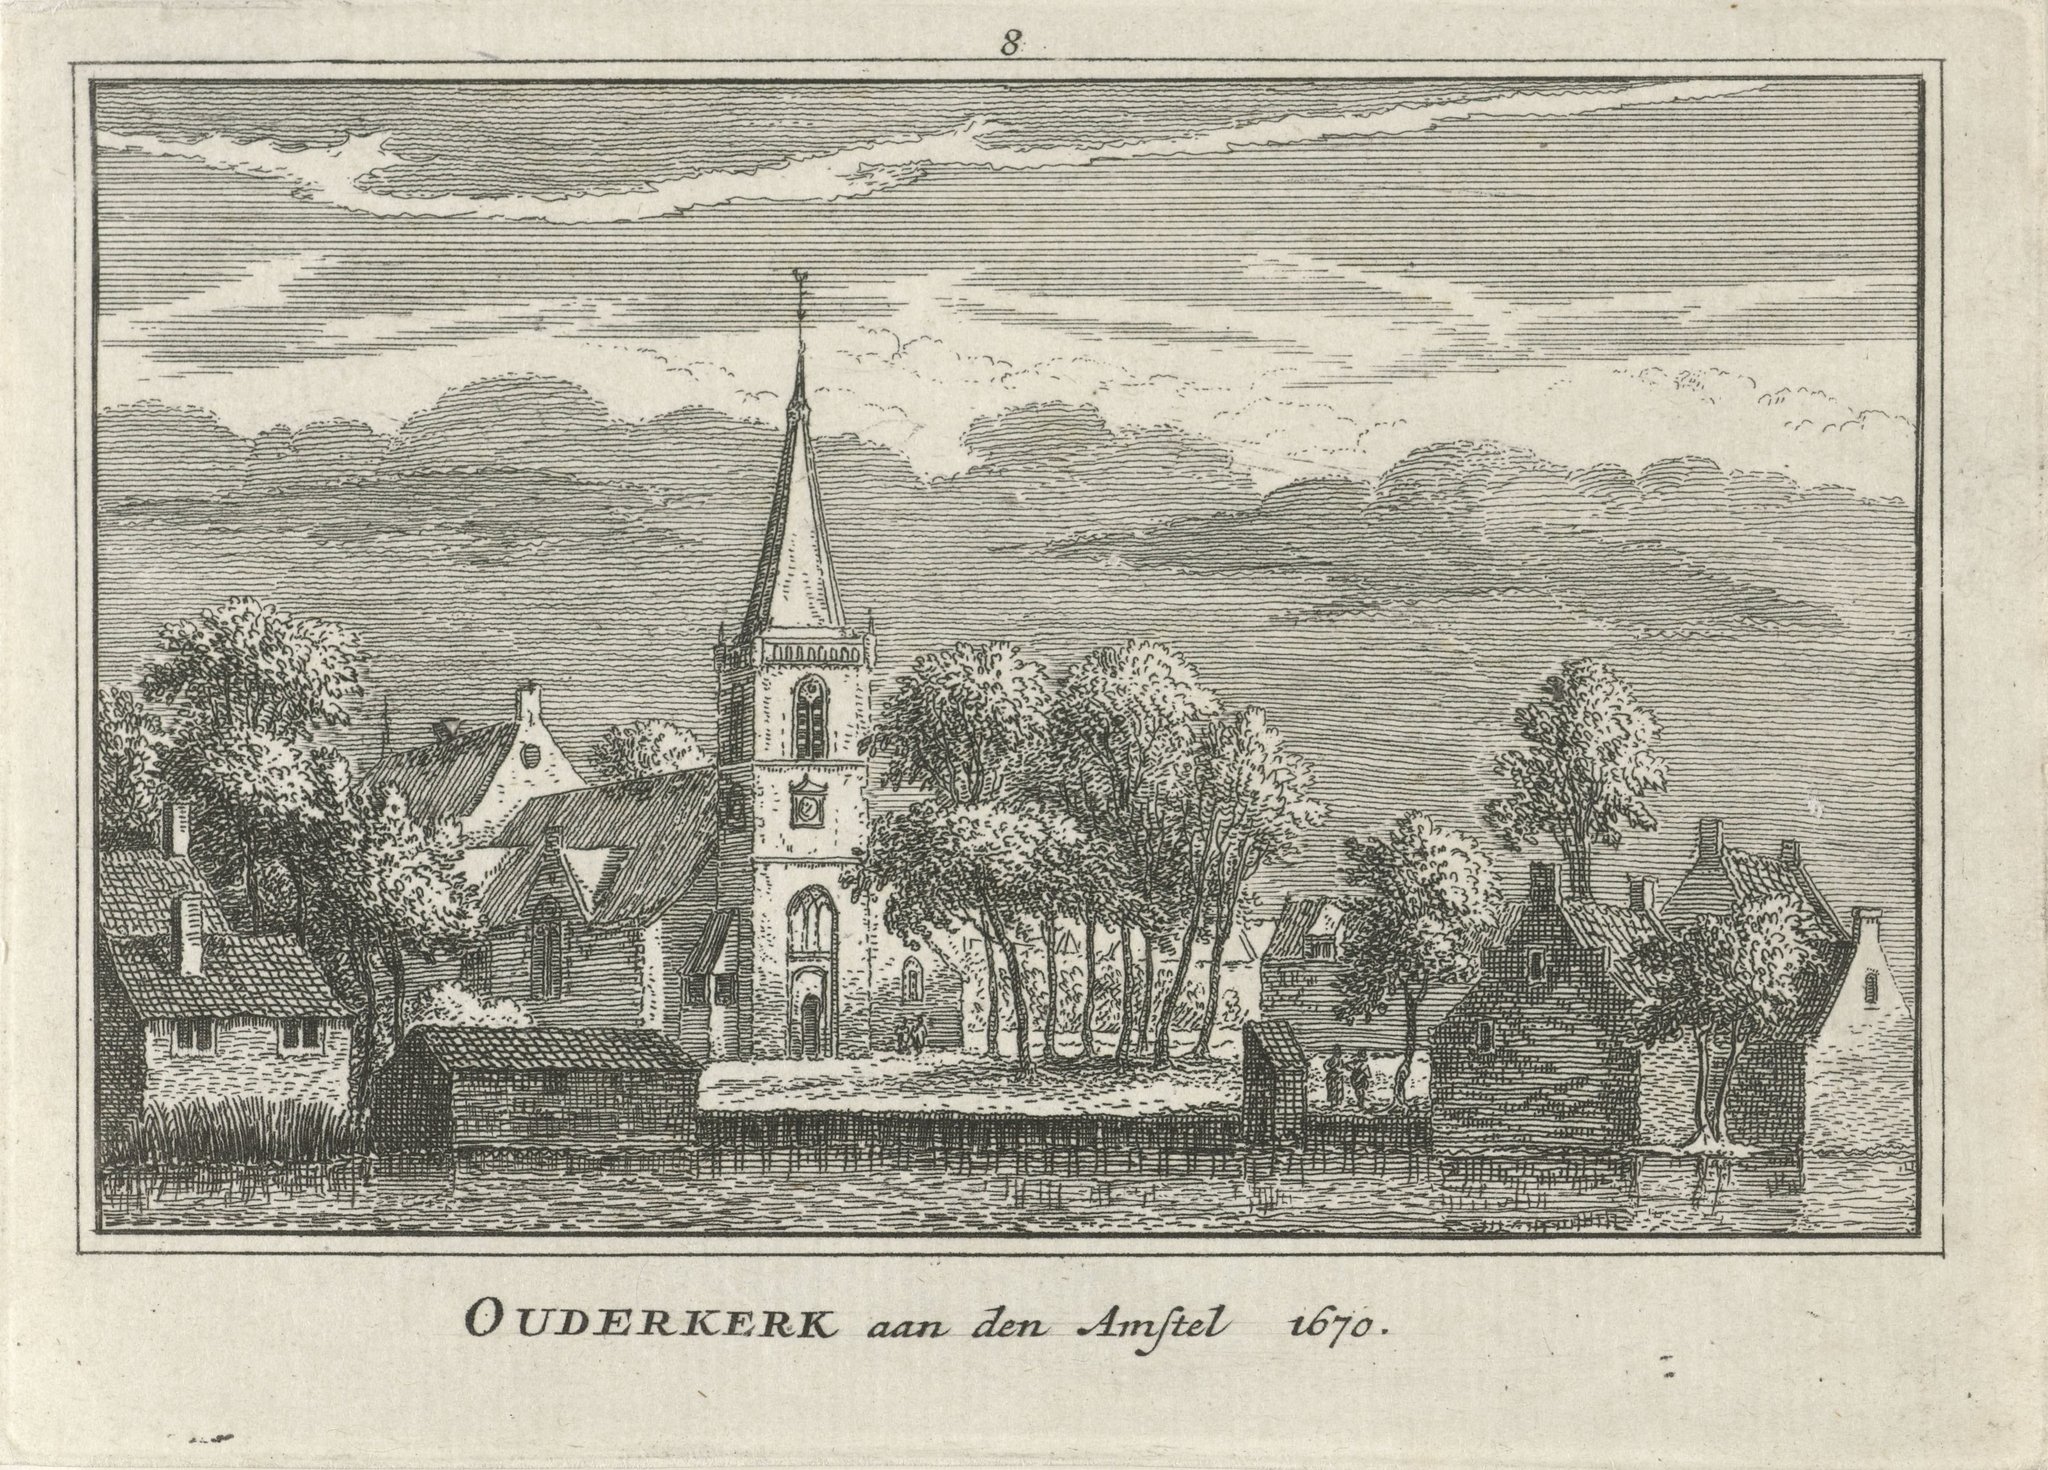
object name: book illustration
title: Ouderkerk aan den Amstel 1670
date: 1727-1733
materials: paper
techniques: etching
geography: amsterdam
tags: church (exterior)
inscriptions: collector's mark: Lugt 2228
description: Illustratie uit: Abraham Rademaker, Matthaeus Brouërius van Niedek, Isaac Le Long, Kabinet van Nederlandsche en Kleefsche outheden en (...) voorname stads- en landgebouwen, Willem Barents en Antoni Schoonenburg: Amsterdam, 1727-1733, ill. nr. 8.